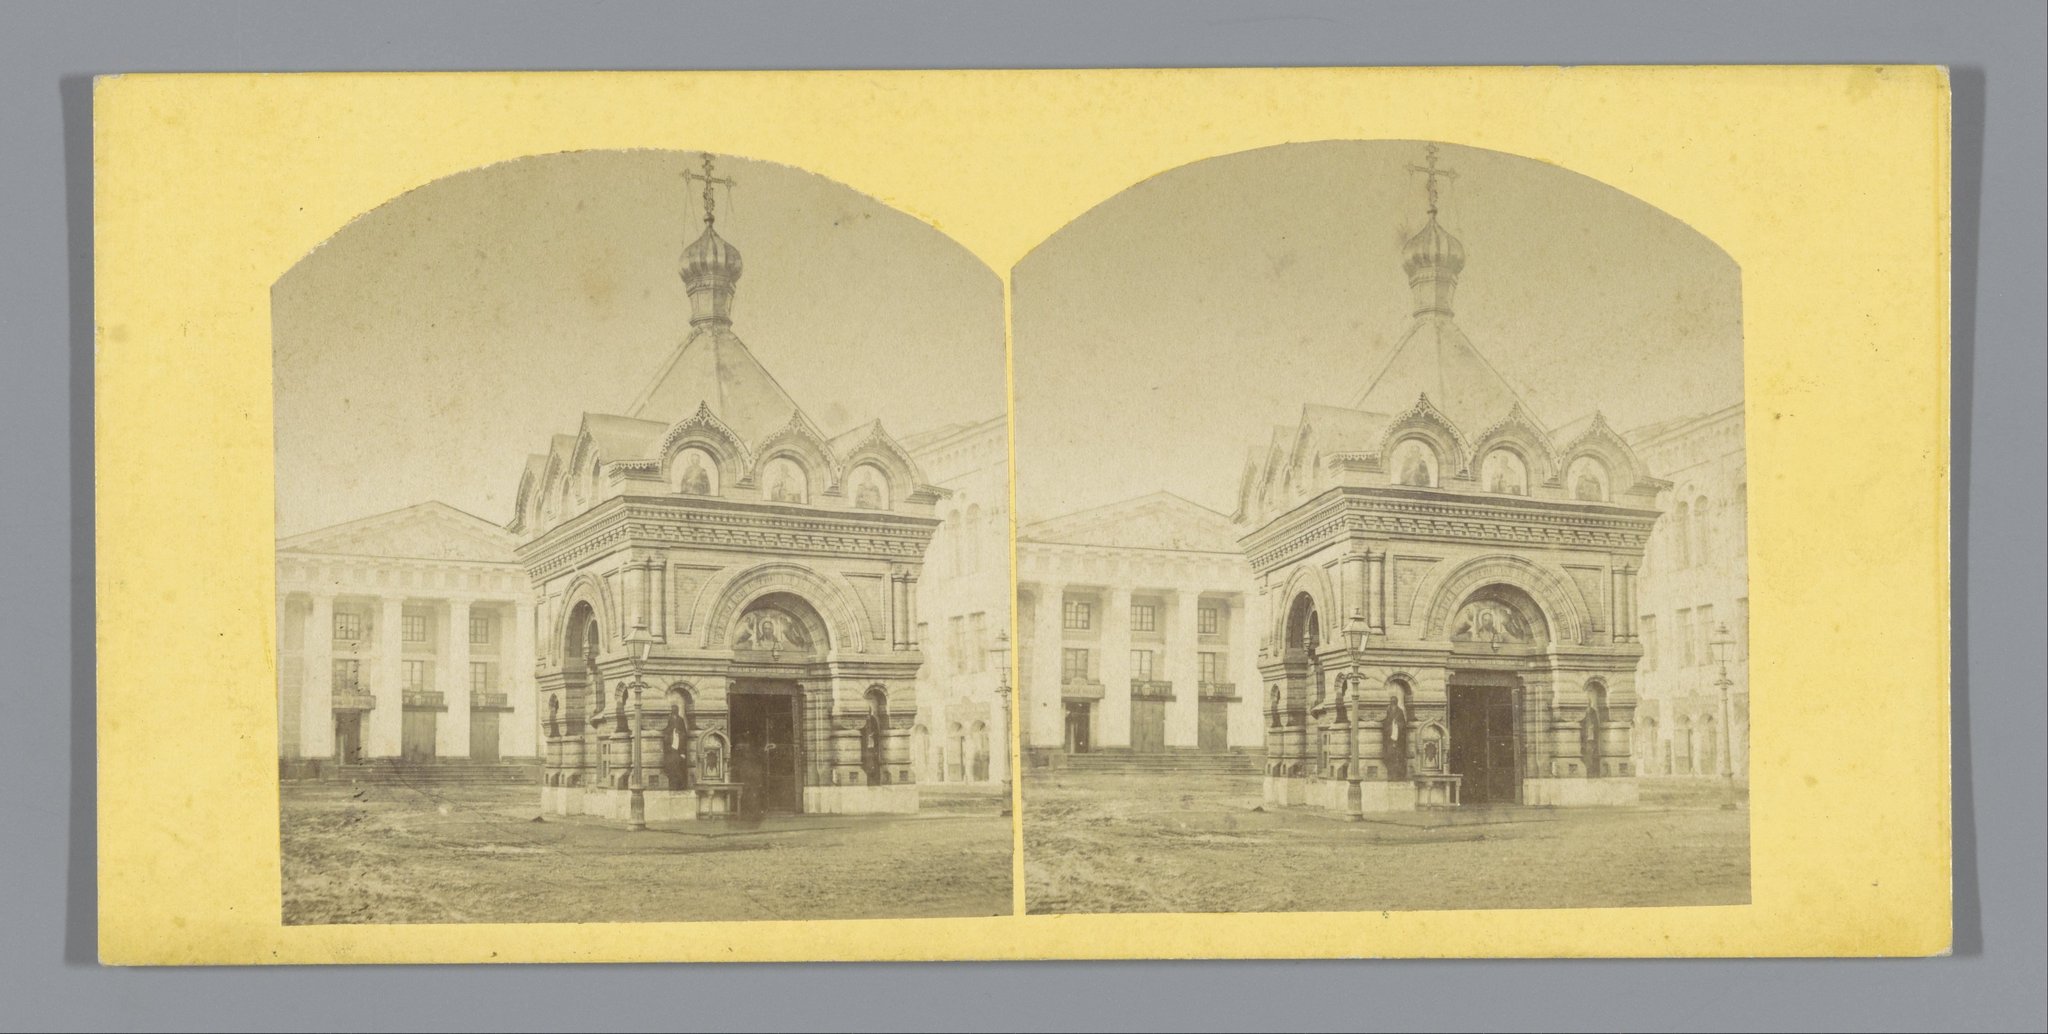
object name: stereograph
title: Kapel op de de Nevski Prospekt in Sint-Petersburg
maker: Anonymous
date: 1850-1880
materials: cardboard, photographic support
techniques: albumen print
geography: sint-petersburg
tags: church (exterior) - qq - small church, chapel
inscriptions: inscription: ‘St. Pétersbourg Chapelle sur la perspective’